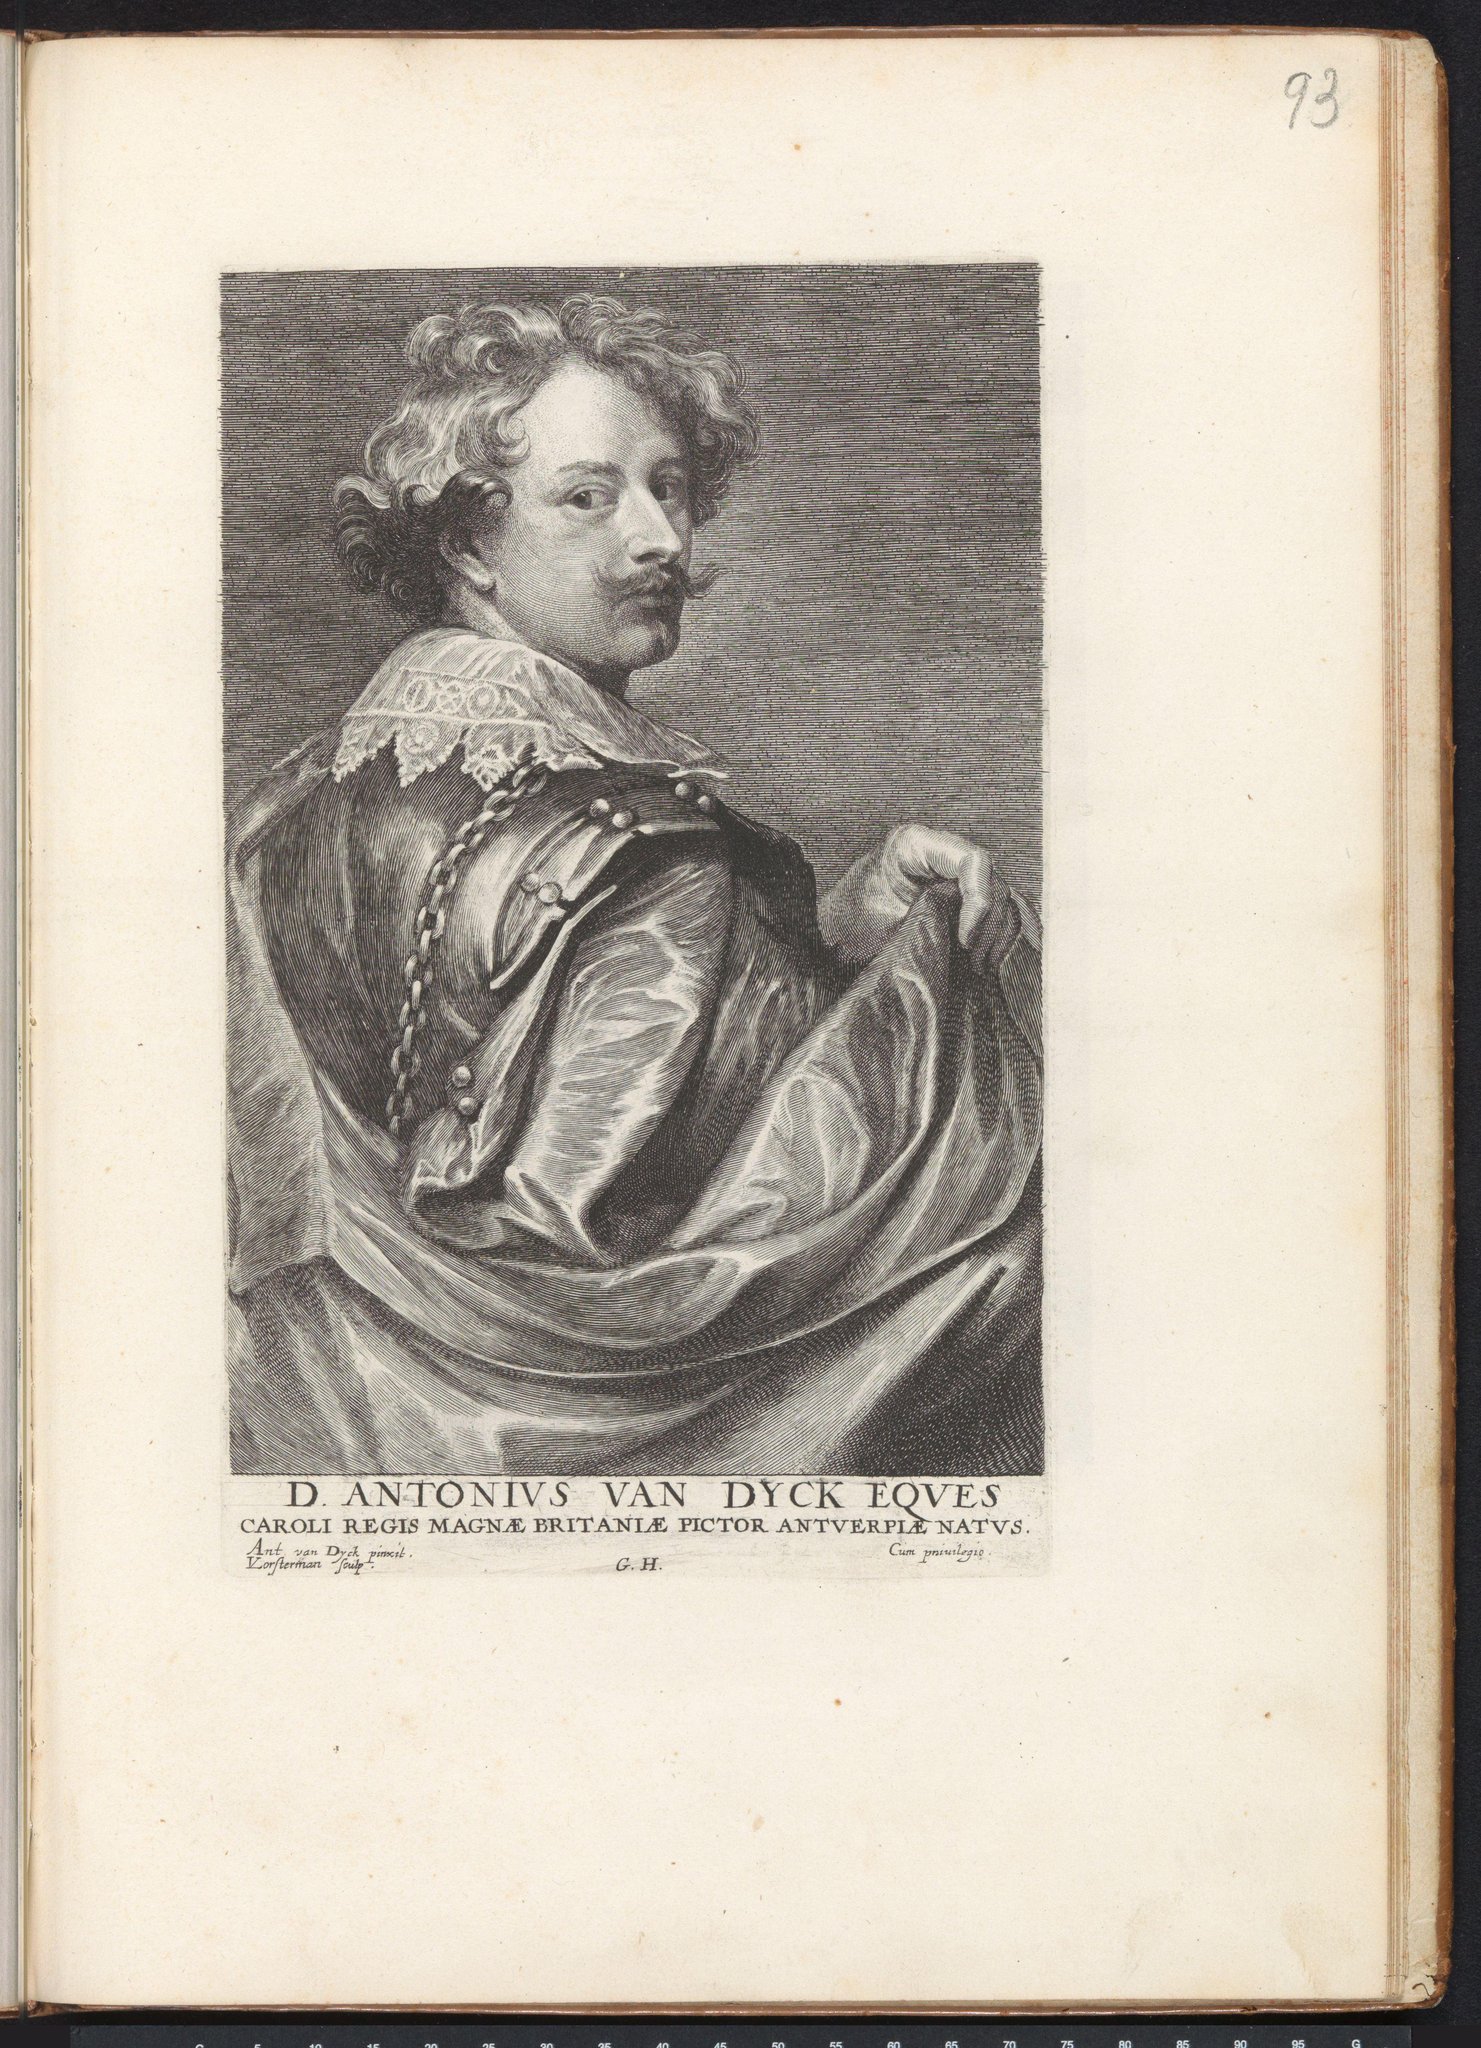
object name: album leaf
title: Portret van de schilder Anthony van Dyck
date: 1630-1641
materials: paper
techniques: engraving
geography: antwerp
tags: antwerp, london, painter, print maker, draughtsman, anthony van dyck, portrait, self-portrait of painter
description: Deze prent maakt deel uit van een album.